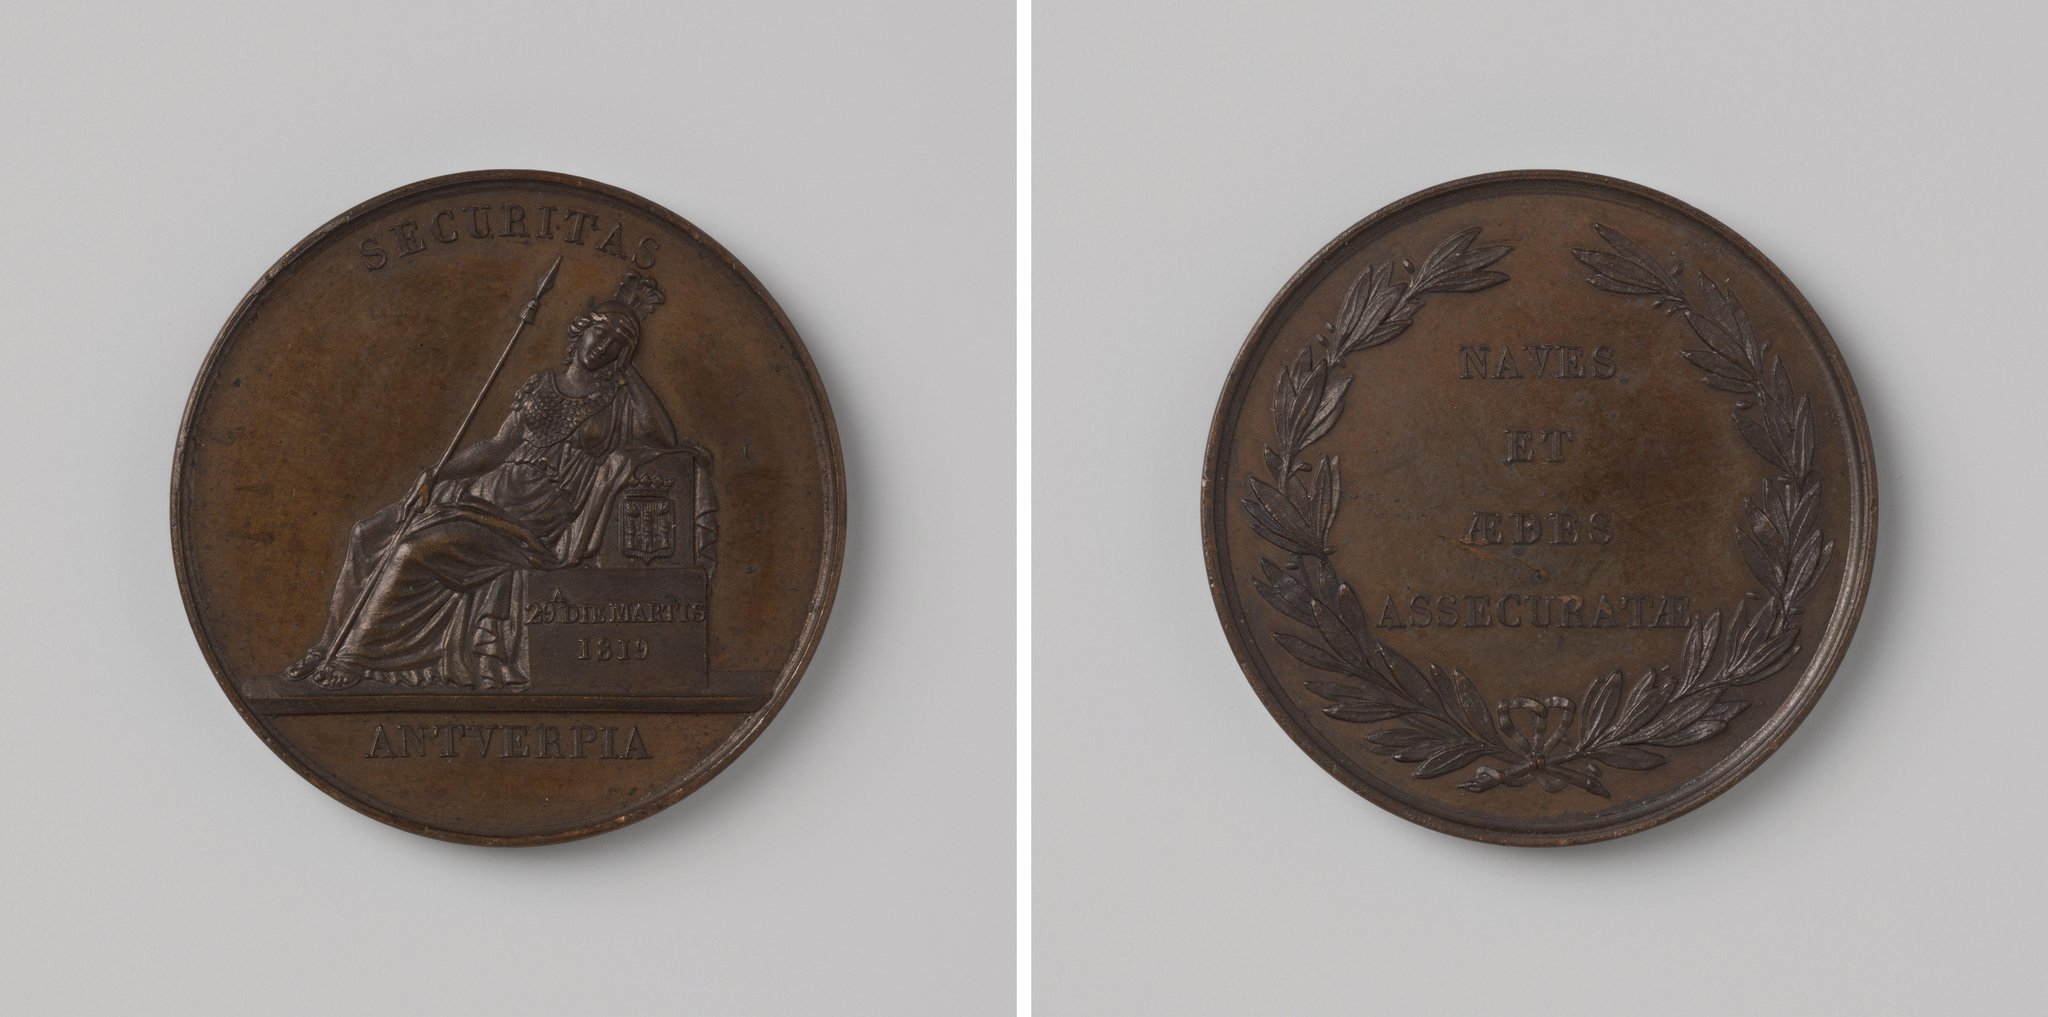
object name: history medal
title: Oprichting van de assurantiemaatschappij Securitas te Antwerpen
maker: Anonymous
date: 1819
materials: bronze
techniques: striking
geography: belgium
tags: antwerp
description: Bronzen penning. Voorzijde: gehelmde vrouw met lans in rechterhand leunt onbezorgd op wapenschild, dat op voetstuk met opschrift staat binnen omschrift; afsnede: opschrift. Keerzijde: opschrift binnen krans van olijftakken